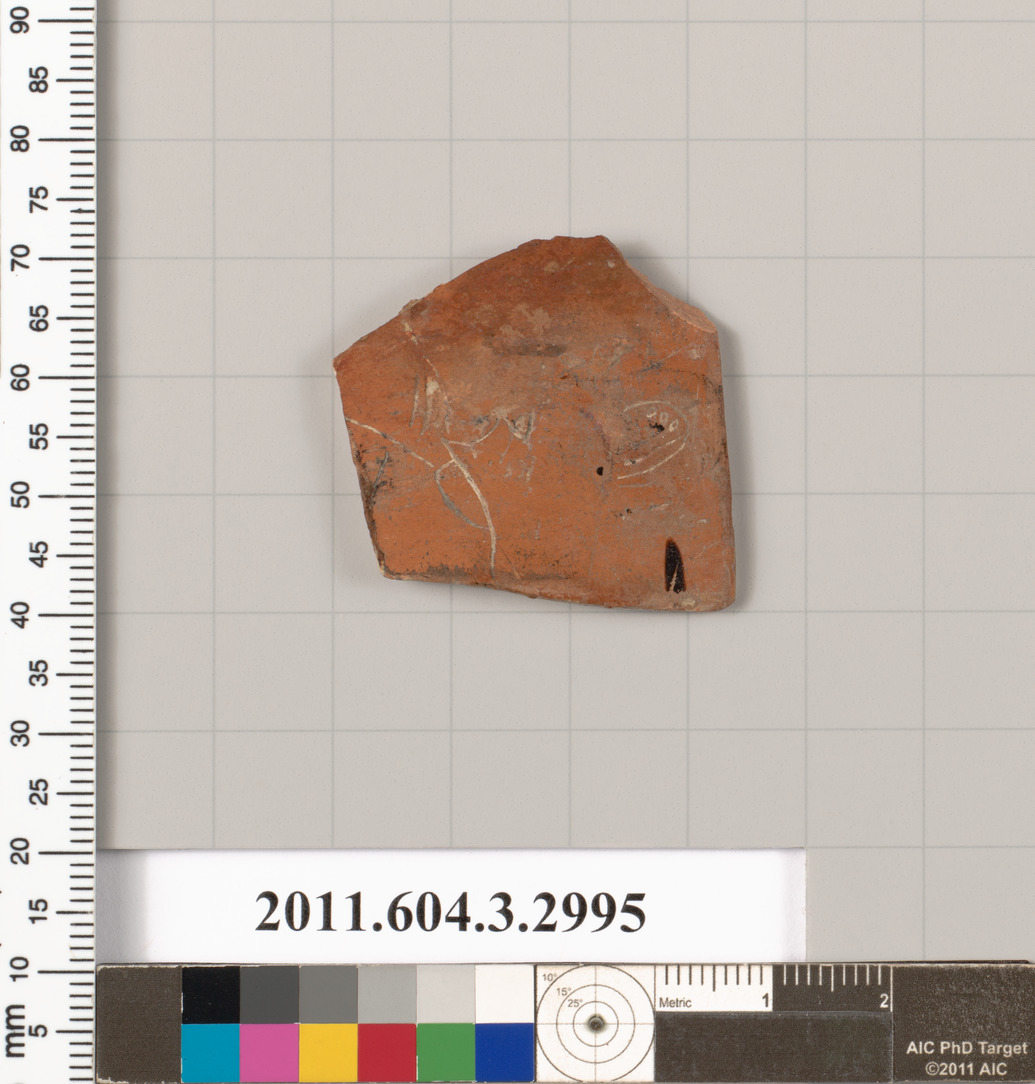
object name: undetermined closed shape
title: Terracotta fragment of a closed shape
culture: greek, attic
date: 600-401 BCE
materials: terracotta